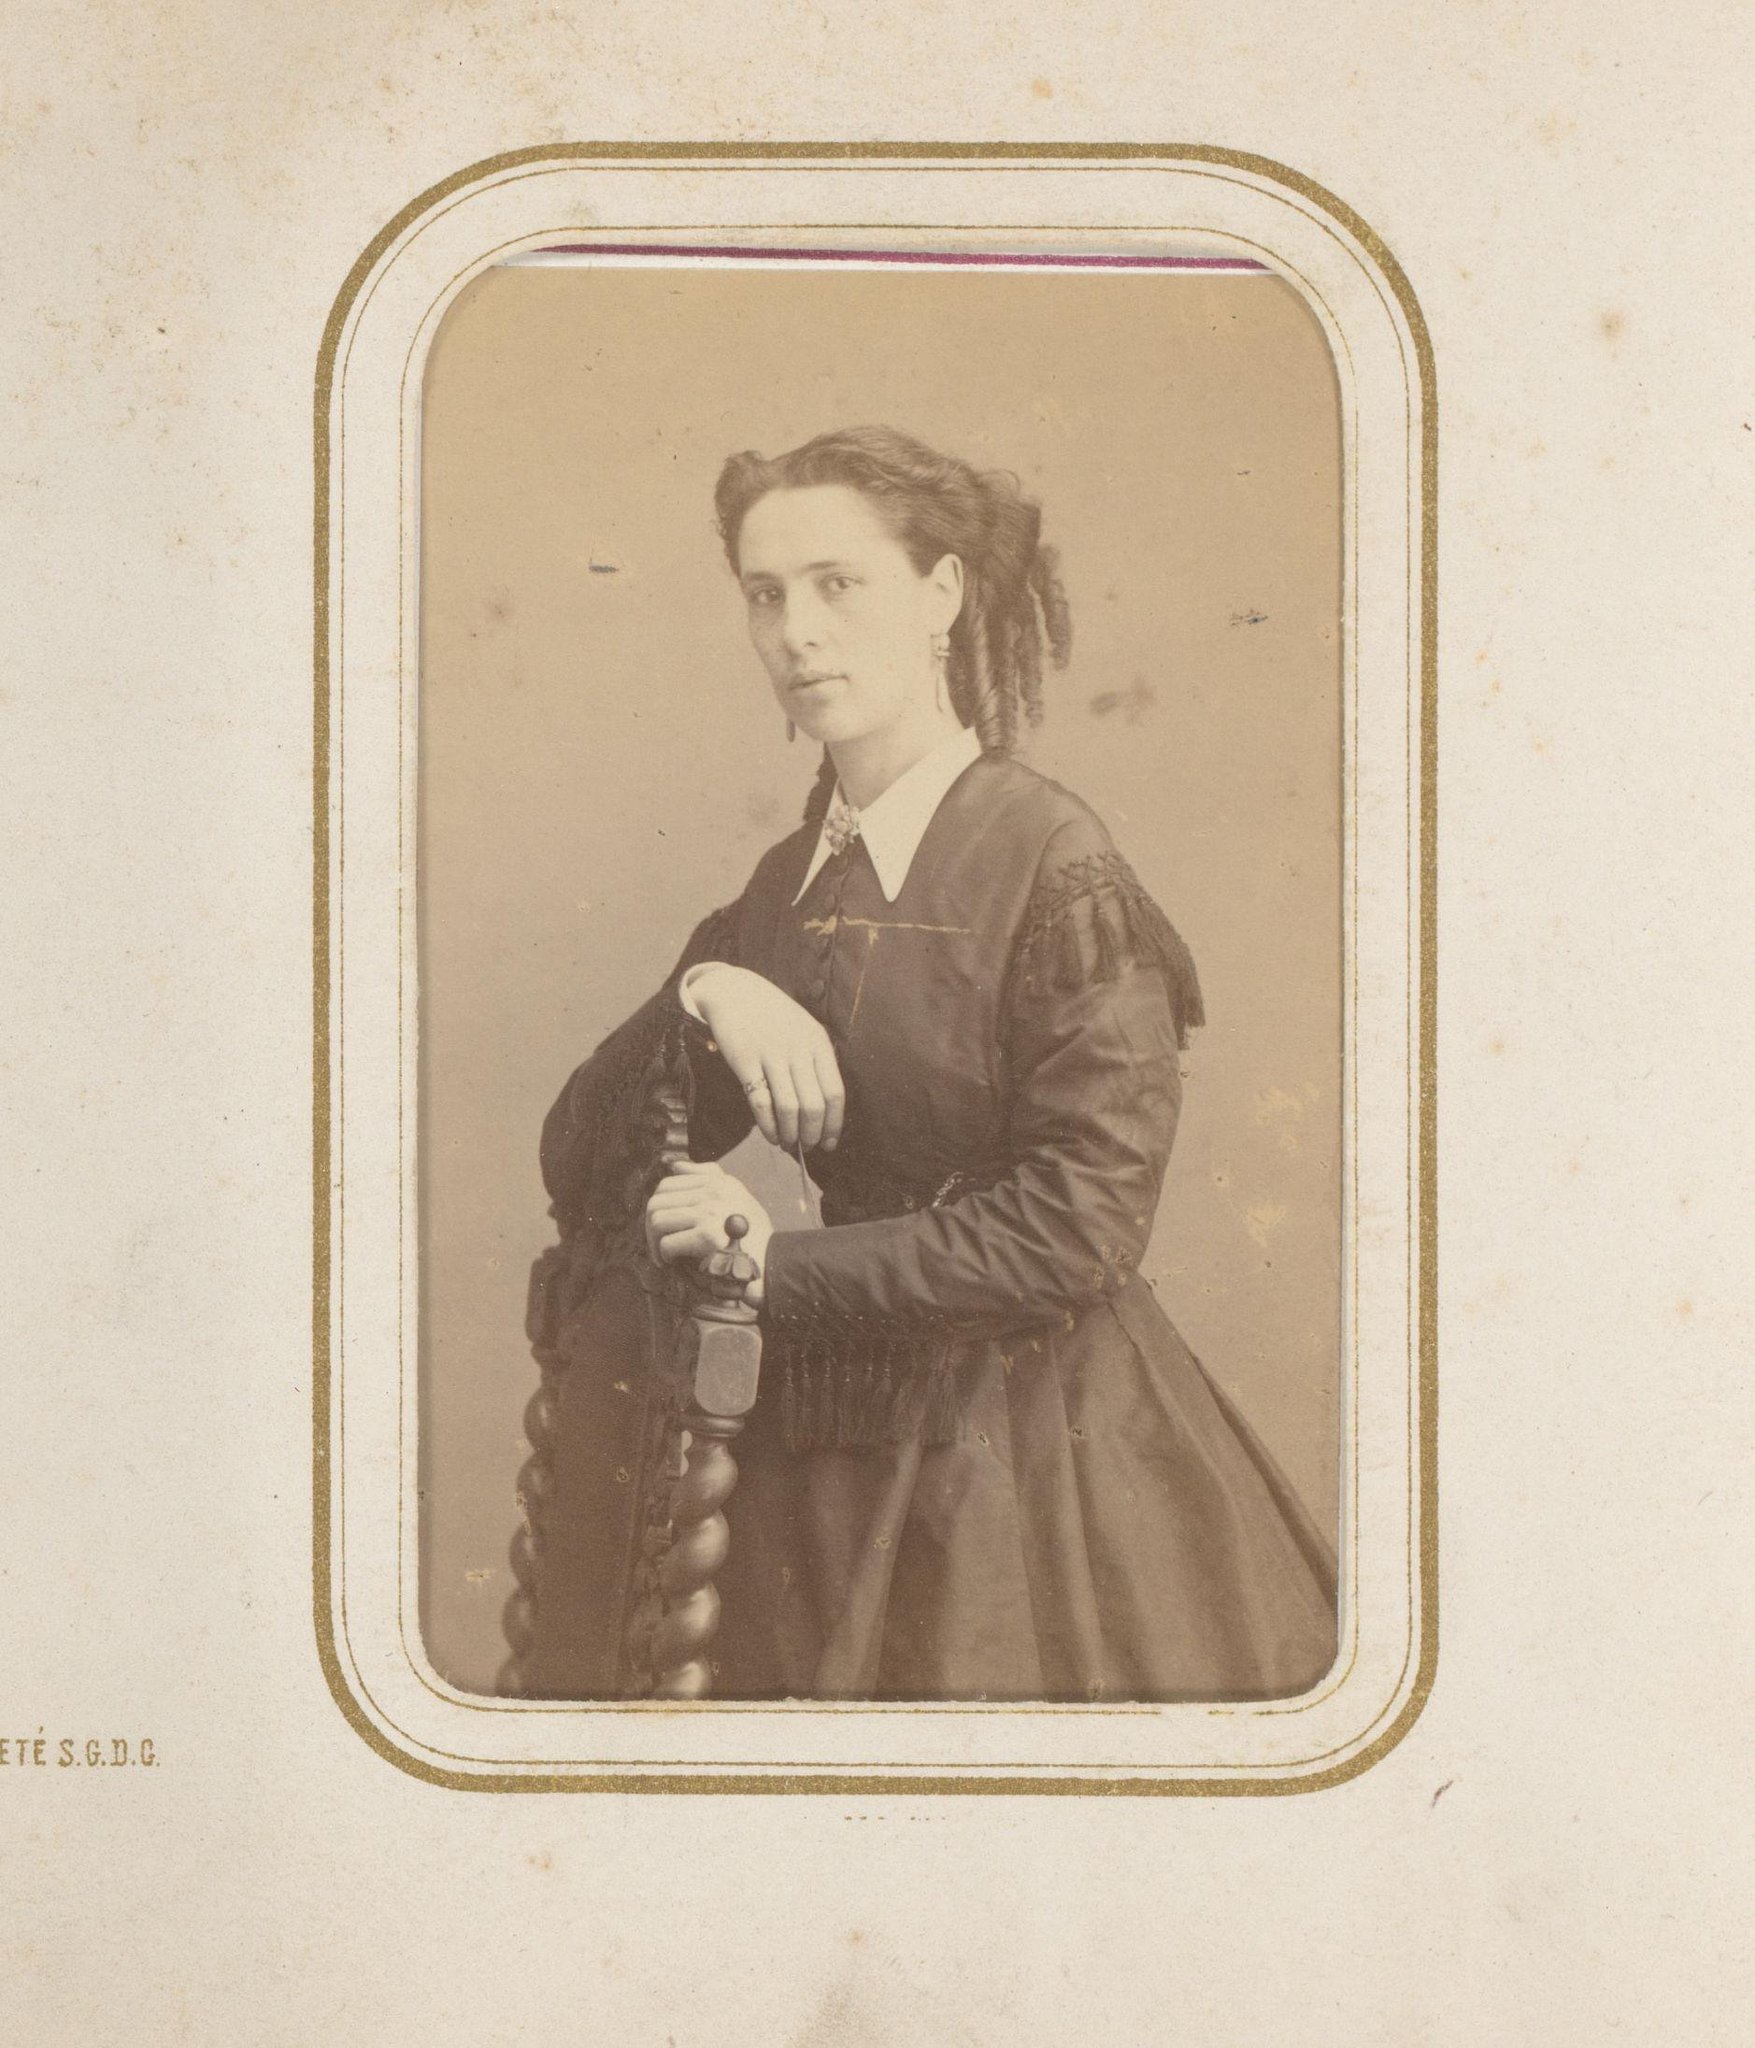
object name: carte de visite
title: Portret van een vrouw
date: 1869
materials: cardboard, photographic support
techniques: albumen print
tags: adult woman, historical persons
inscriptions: inscription: ‘Numa Fills/ Photographe/ 49, Rue Vivienne 49/ Paris’, annotation: ‘Souvenur/ de/ Mathilde/ Paris, 12 agosto 69’